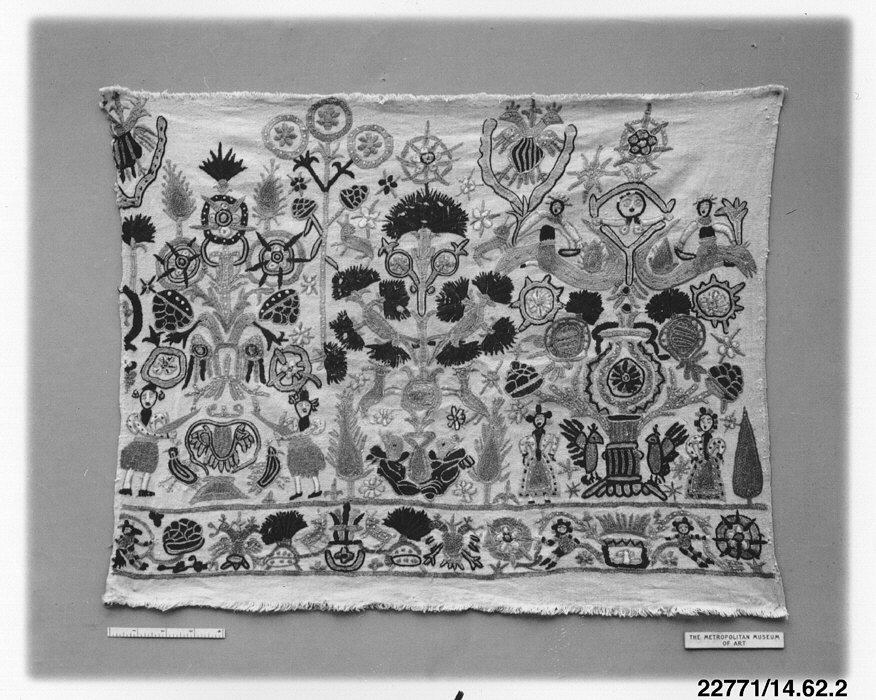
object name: border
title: Part of a border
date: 1701-1800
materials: linen, silk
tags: birds,men,women,flowers